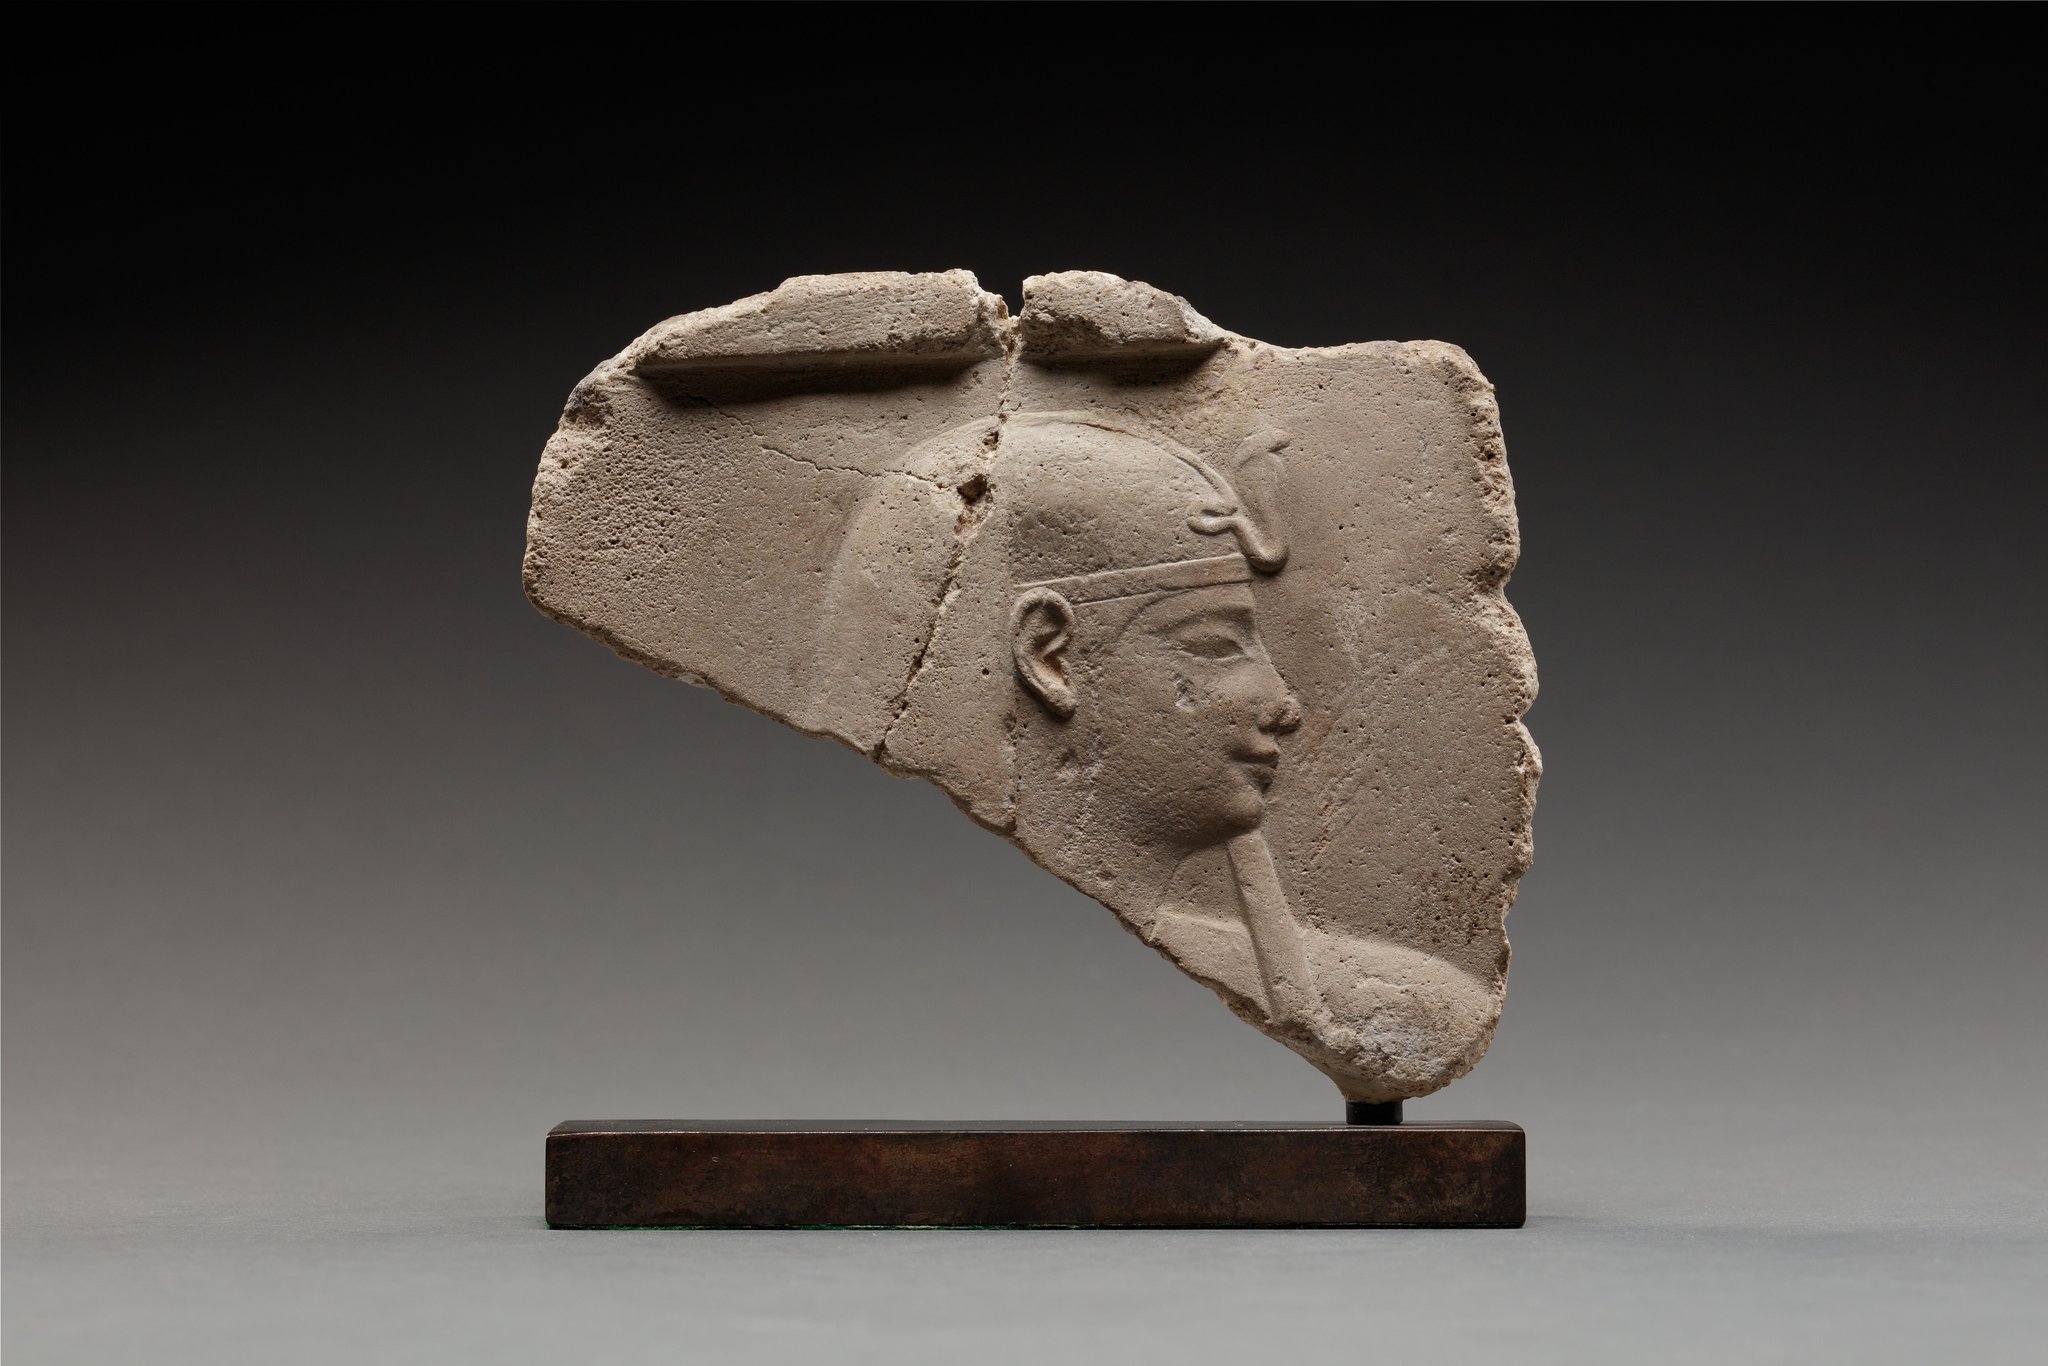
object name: relief, plaque, sculptor's model, donation, royal, head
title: Relief plaque depicting a royal figure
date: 300-201 BCE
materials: limestone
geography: egypt